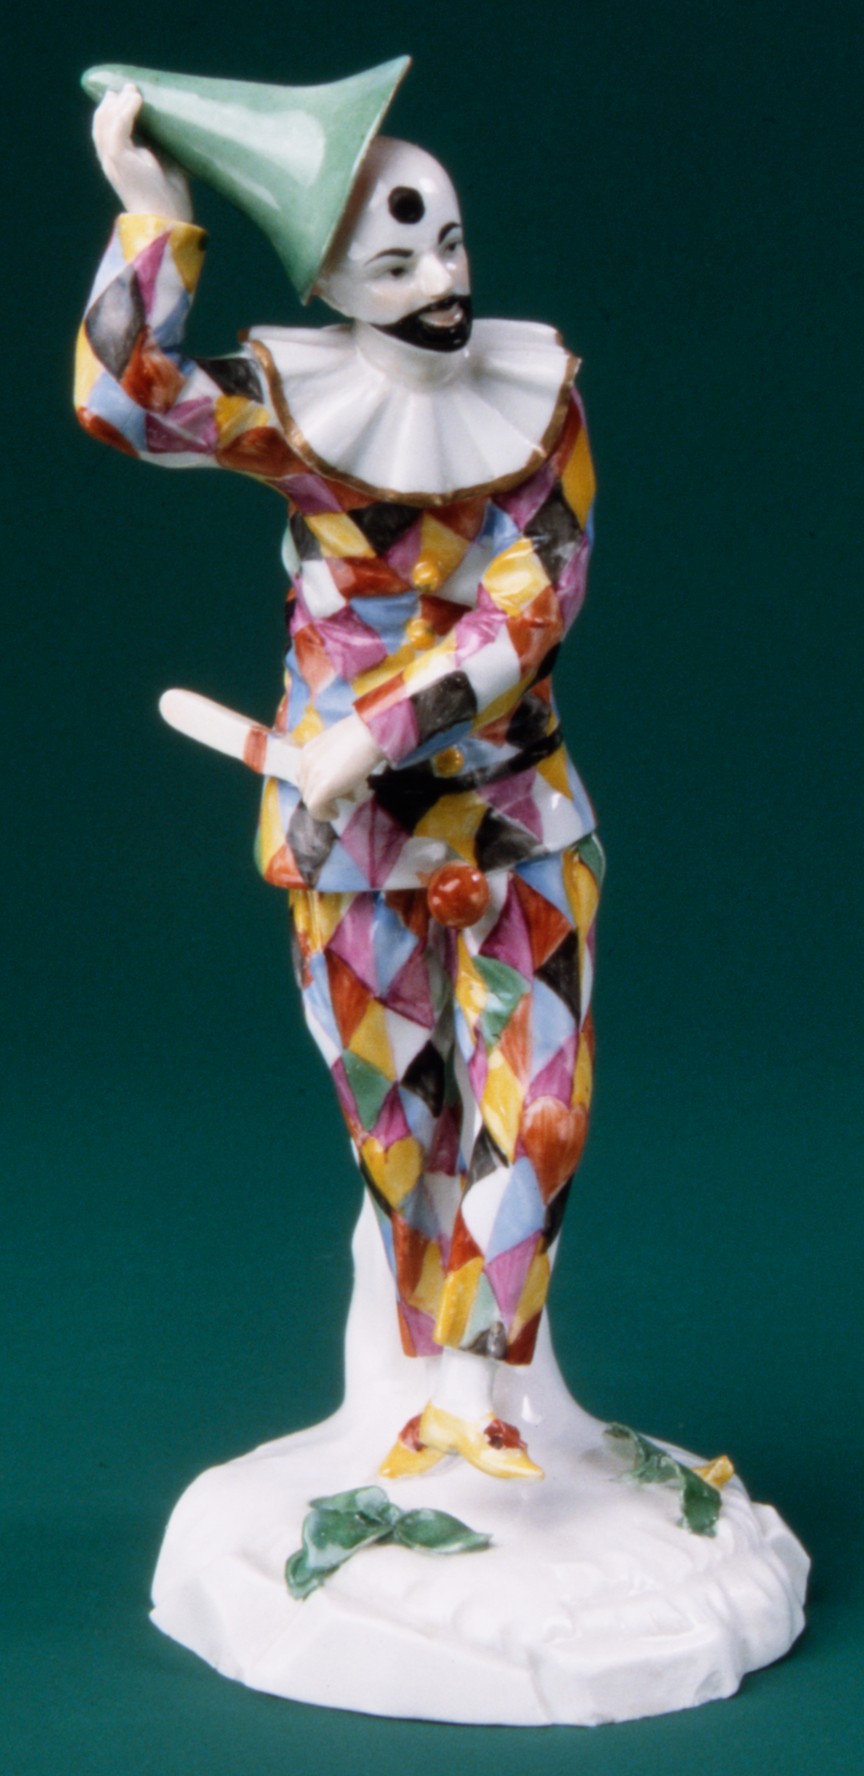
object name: figure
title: Harlequin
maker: fulda pottery and porcelain manufactory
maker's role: manufactory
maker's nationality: german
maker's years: 1764-1789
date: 1770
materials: hard paste porcelain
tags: men